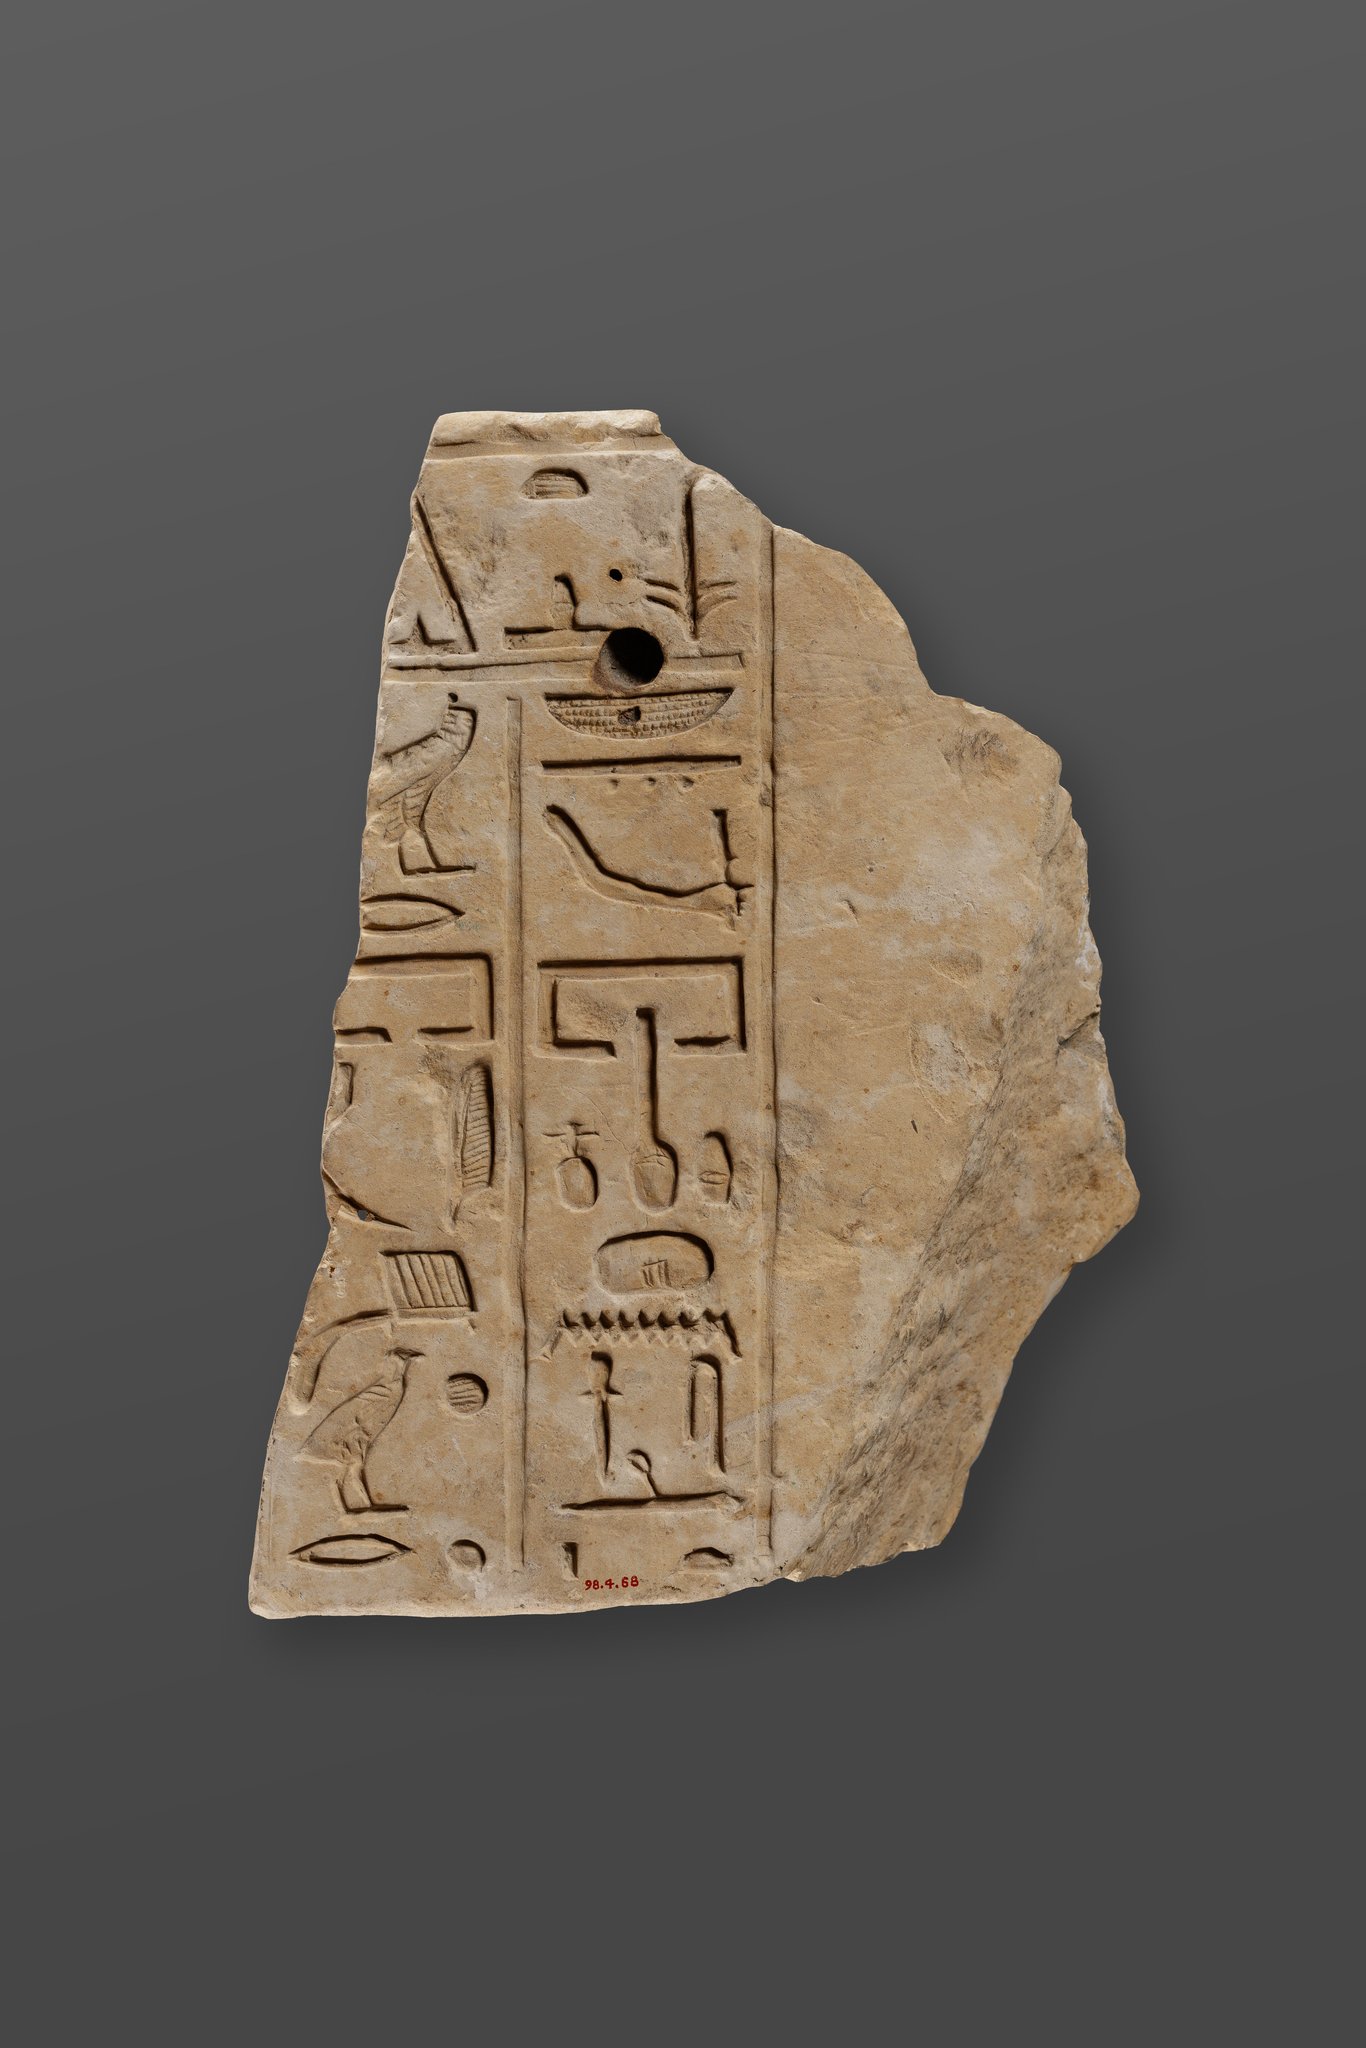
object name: stela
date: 2100-2090 BCE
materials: limestone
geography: egypt